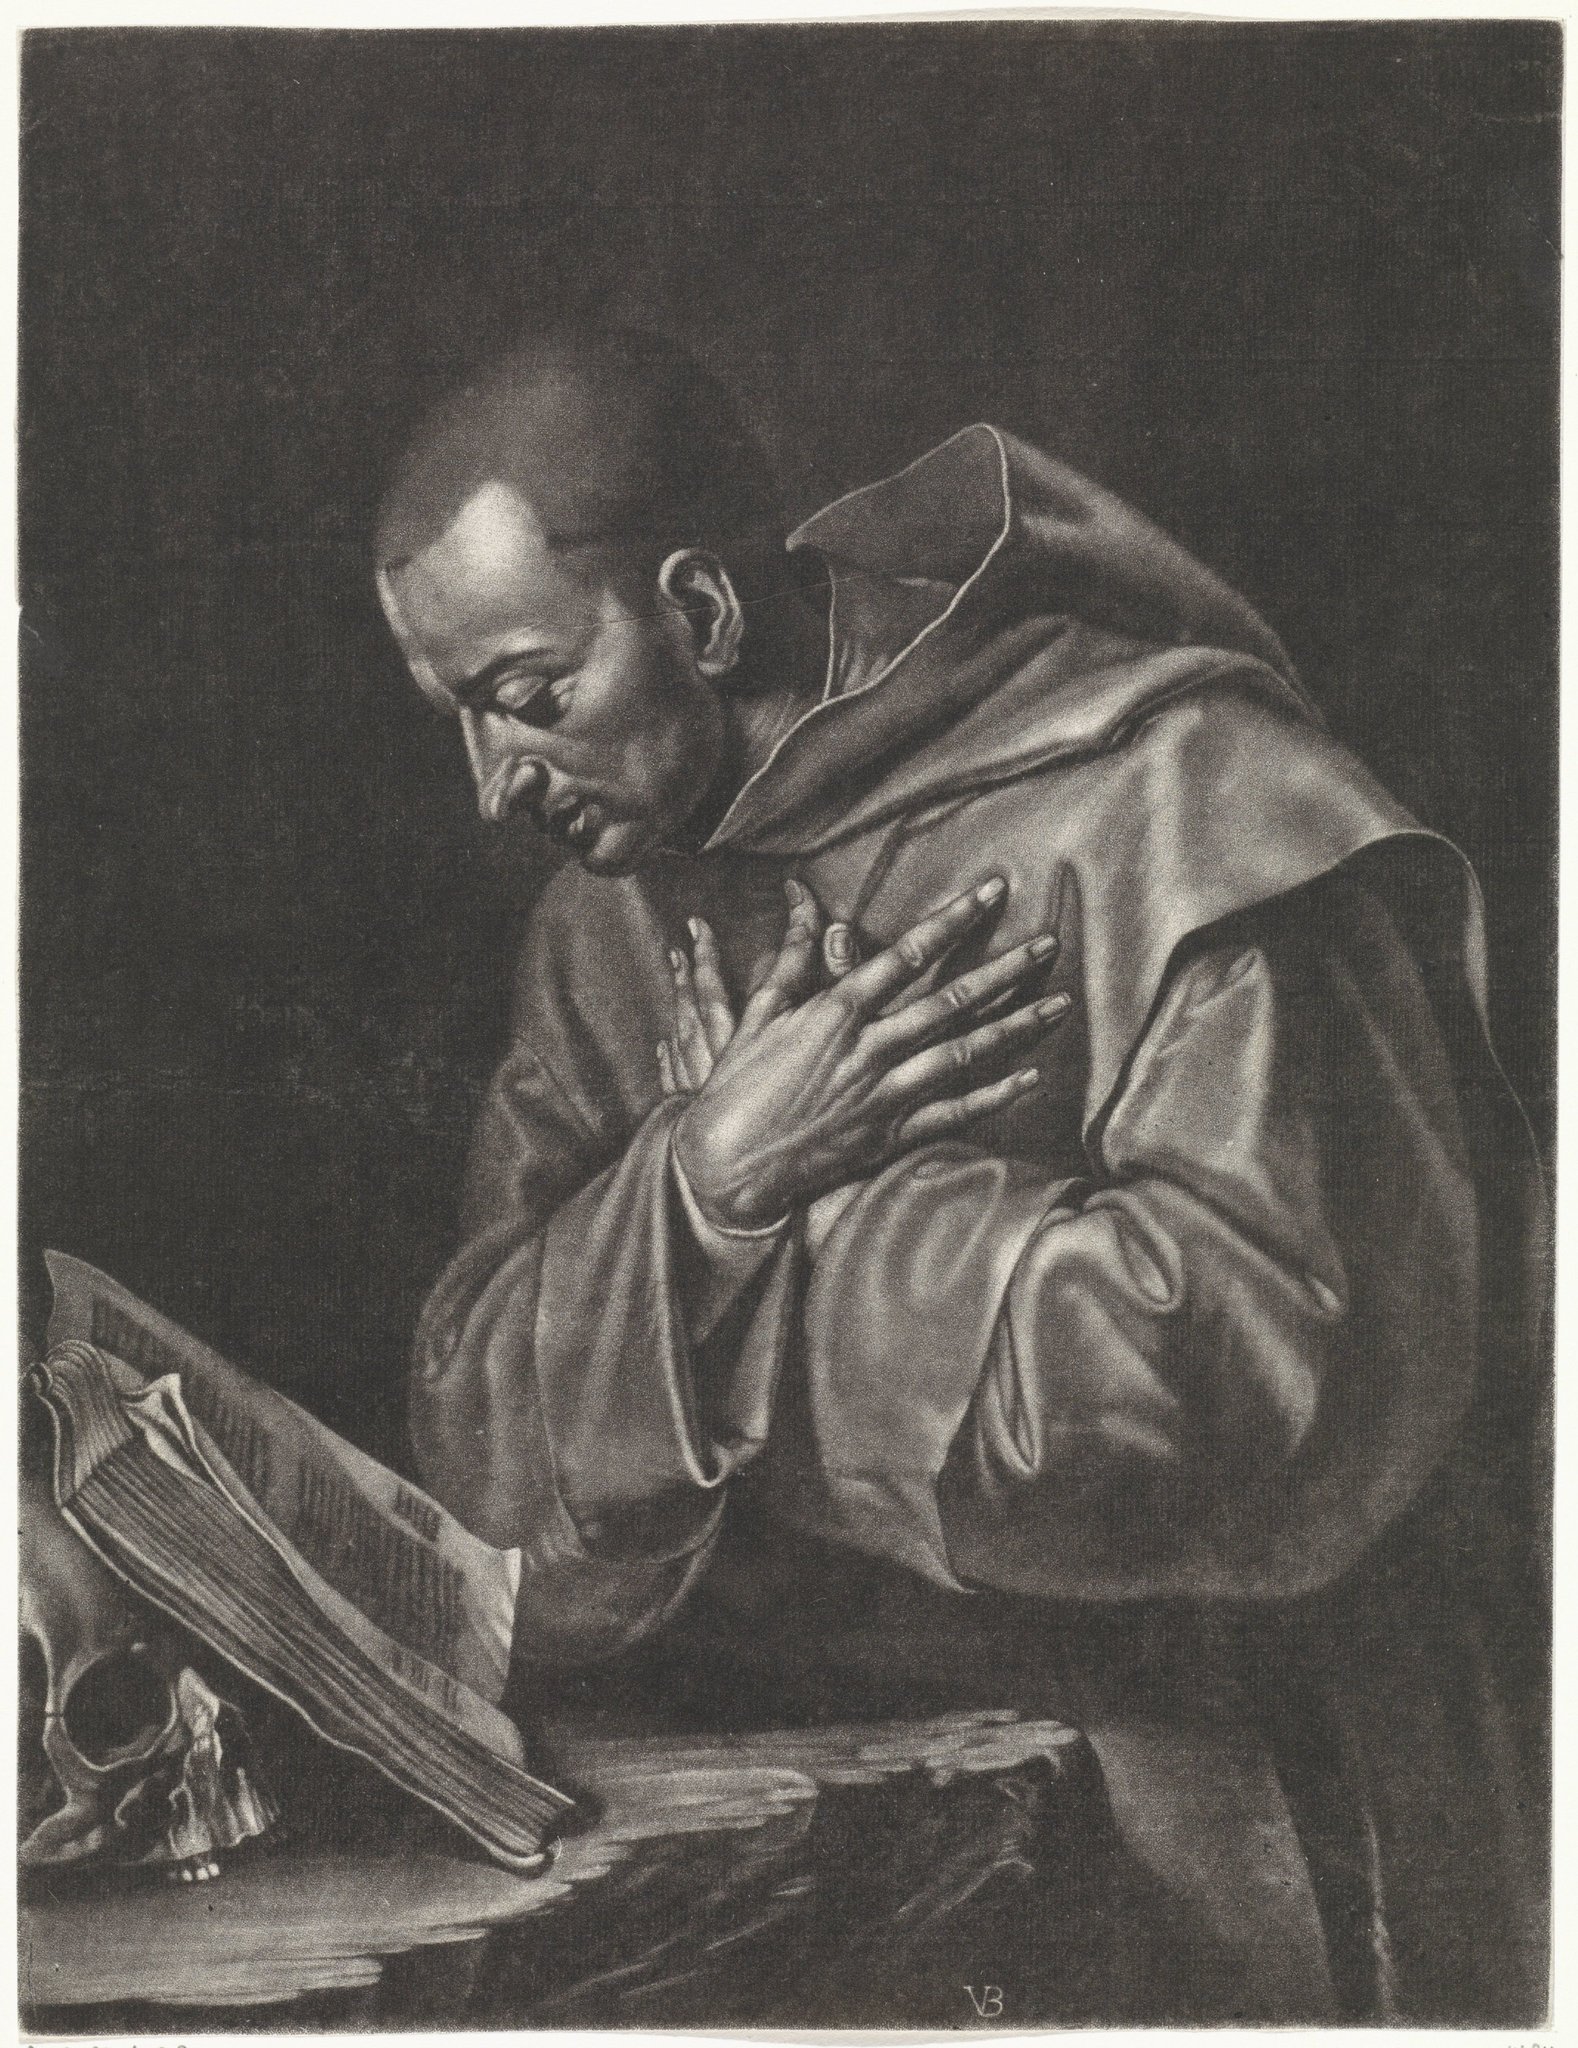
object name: print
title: H. Bruno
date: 1659-1740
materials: paper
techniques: mezzotint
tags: bible, (human) skull, the founder of the order of the carthusians, bruno; possible attributes: cross, finger at lips, lily, mitre at his feet, olive-branch, ray of light, skull, (seven) star(s)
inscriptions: collector's mark: Lugt 240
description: De H. Bruno bidt. Voor hem liggen een bijbel en een mensenschedel.